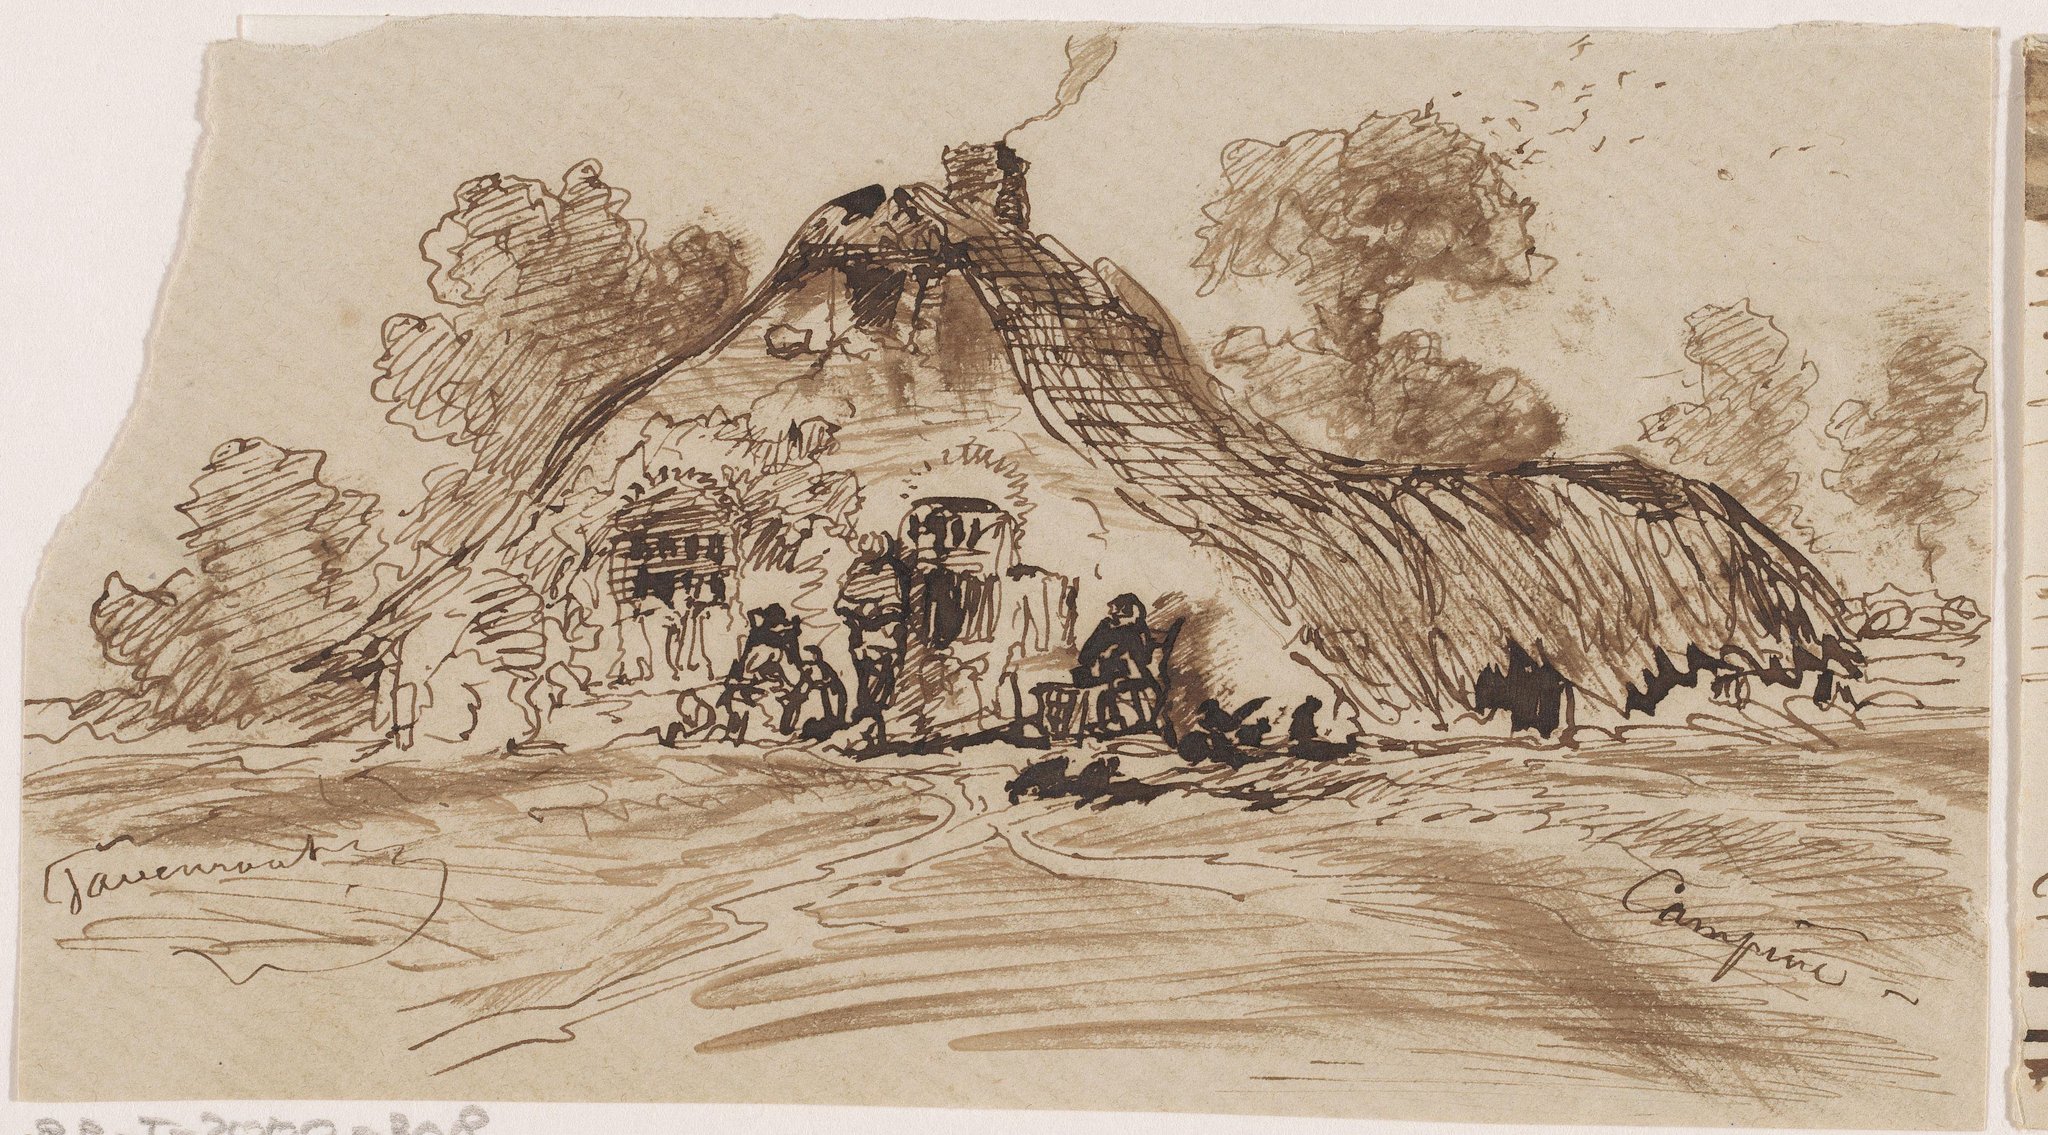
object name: drawing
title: Boerderij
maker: johannes tavenraat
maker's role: draughtsman, painter, print maker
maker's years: 1809-1881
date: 1840-1880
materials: ink, paper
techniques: brush, pen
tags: farm (building)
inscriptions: signature: ‘Tavenraat’, annotation: ‘Campine’, collector's mark: Lugt 2228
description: Enkele figuren buiten voor de deur van een boerderij met laaghangend rieten dak. Getekend op een deel van een envelop of brief gericht aan J. Tavenraat.